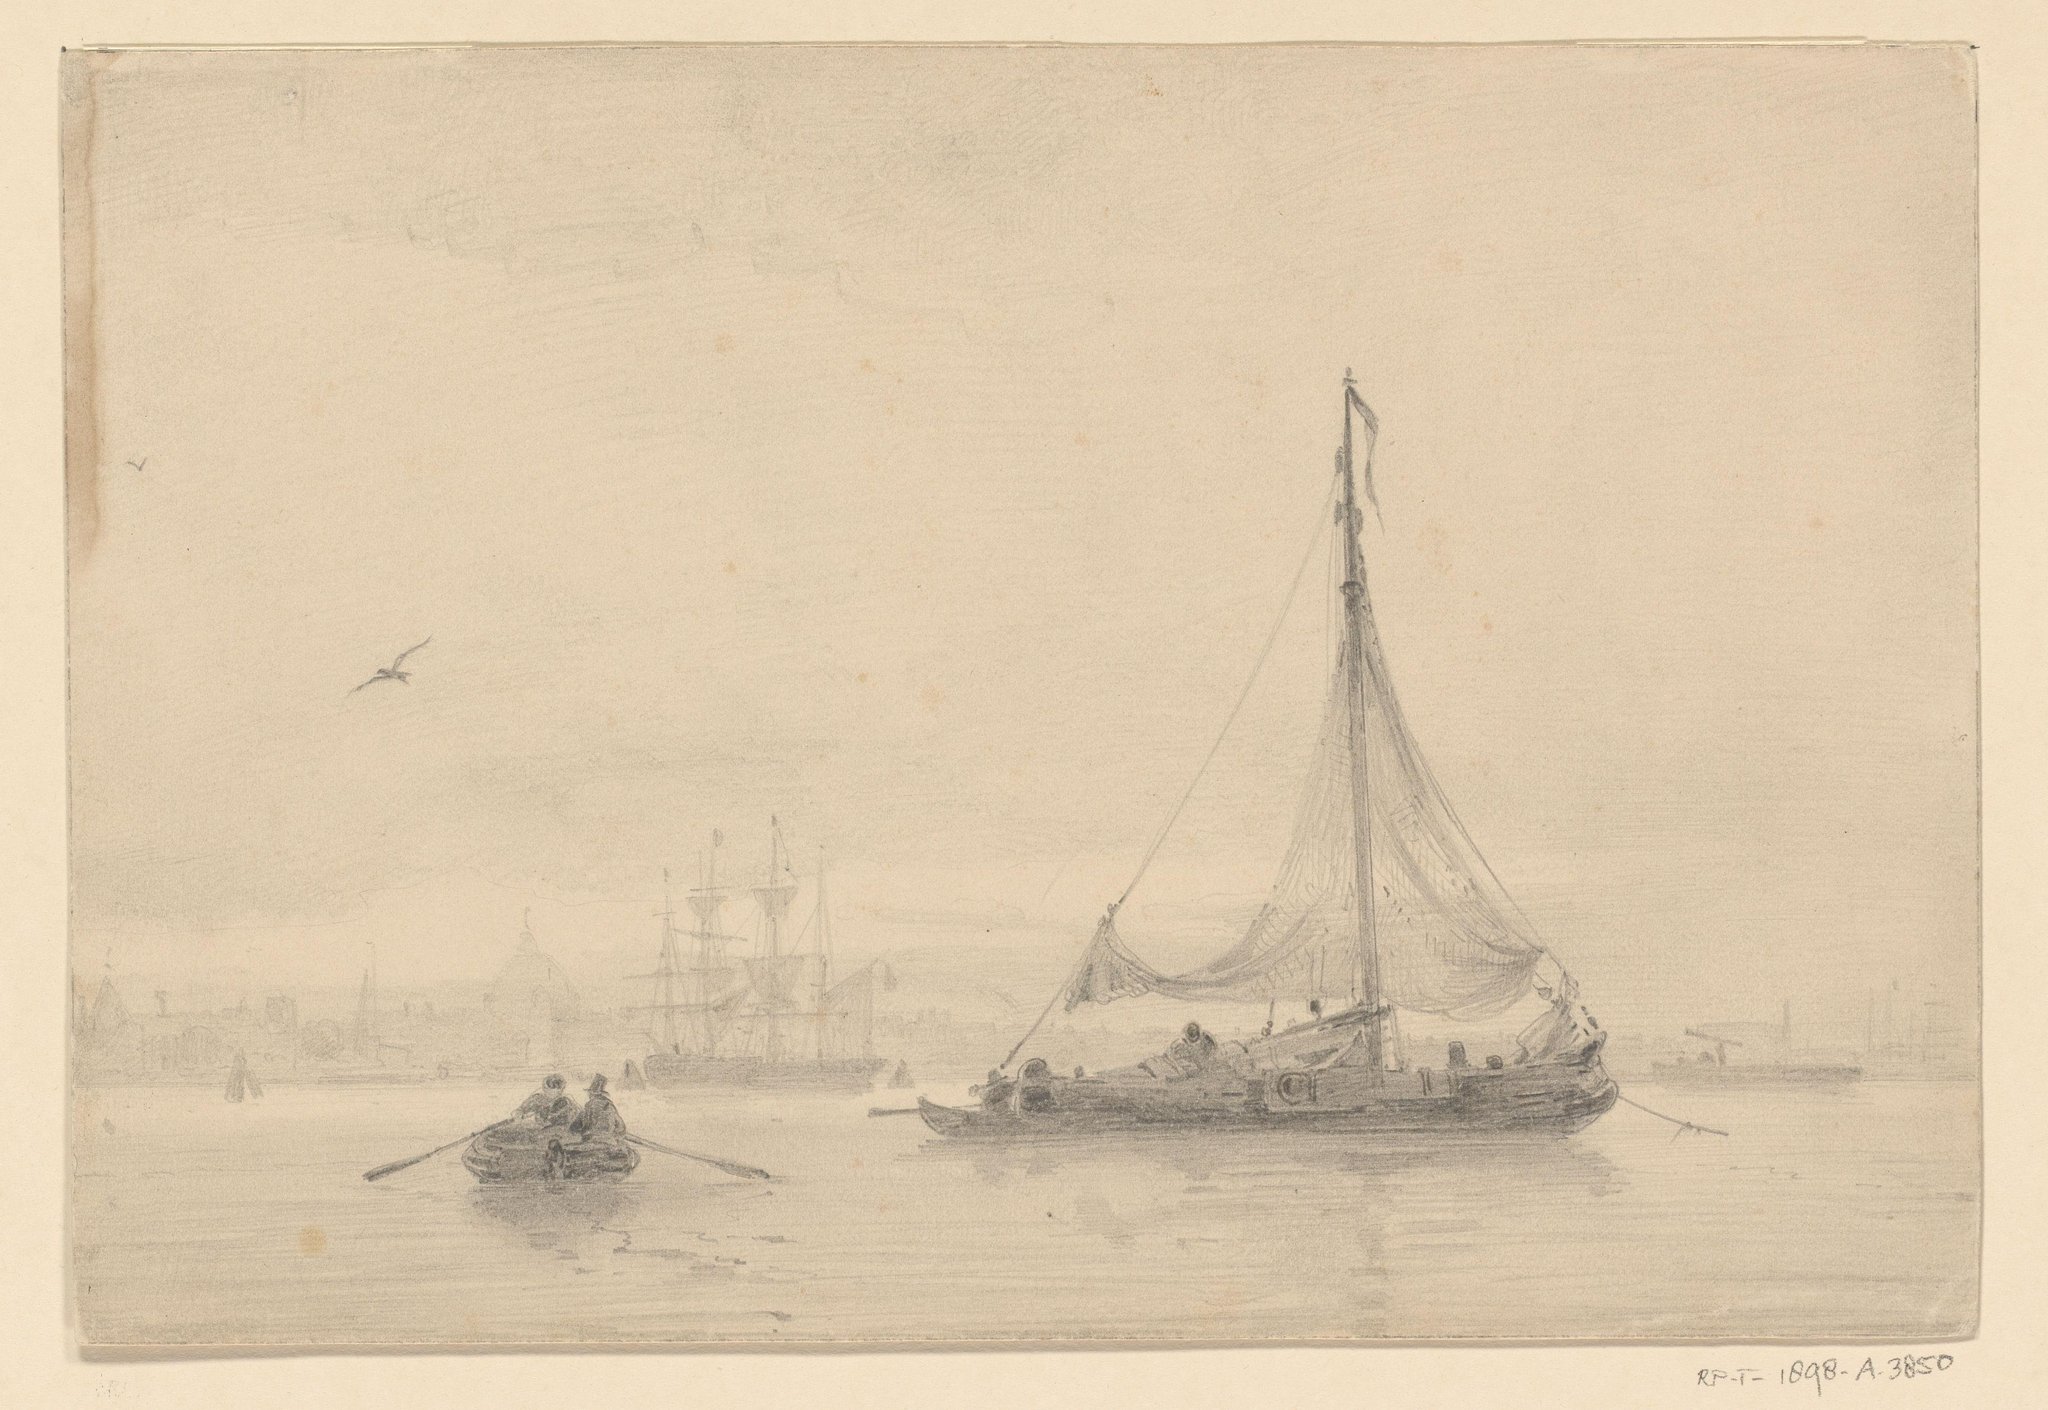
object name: drawing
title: Schepen op het water, in de verte het profiel van een stad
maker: willem anthonie van deventer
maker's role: draughtsman, painter, print maker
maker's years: 1824-1893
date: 1834-1893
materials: paper, pencil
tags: sailing-ship, sailing-boat